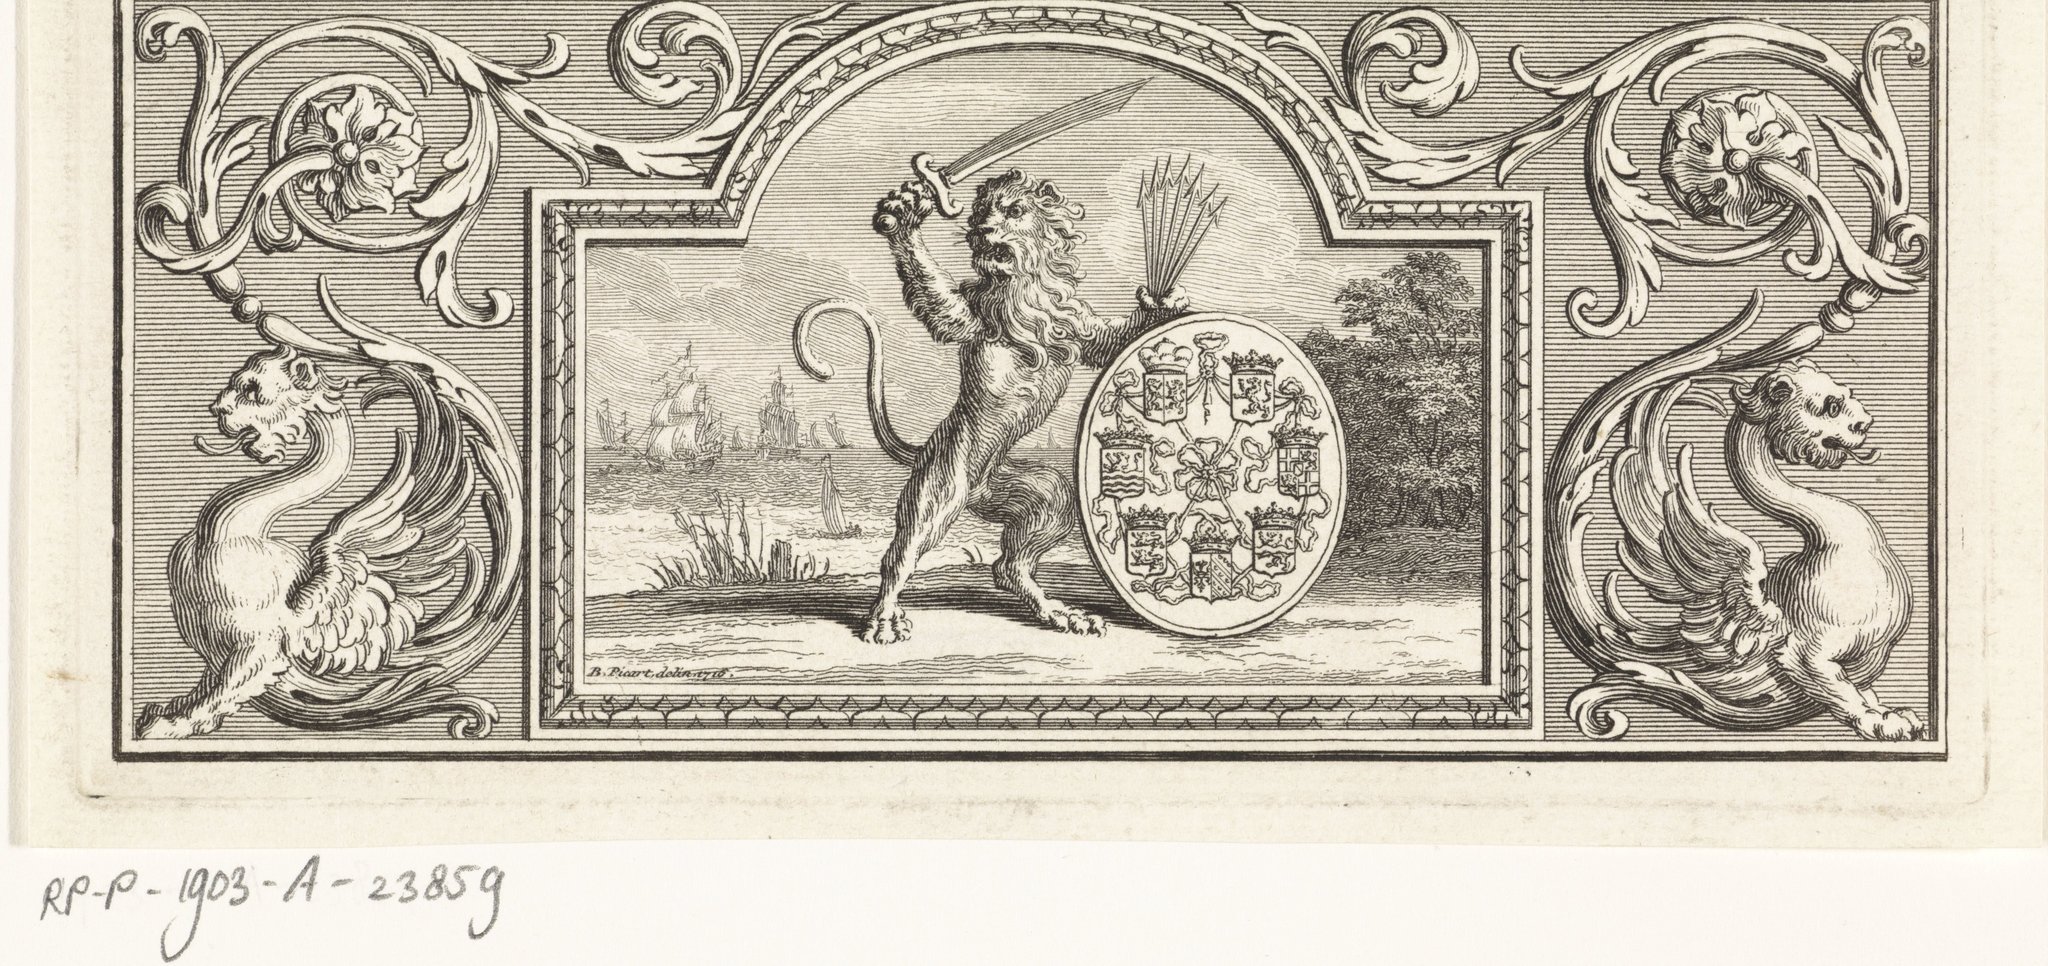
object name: book illustration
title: Hollandse leeuw die het wapen van de zeven provincieën vasthoudt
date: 1716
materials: paper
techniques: engraving, etching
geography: the hague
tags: coat of arms (as symbol of the state, etc.), ornaments ~ art, symbols of particular nations, states, districts, etc.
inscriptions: collector's mark: Lugt 2228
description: De Hollandse leeuw met zwaard en de bundel pijlen in de handen bij een schild met de wapenschilden van de Zeven Provincieën. De voorstelling is gevat in een ornamentele lijst.